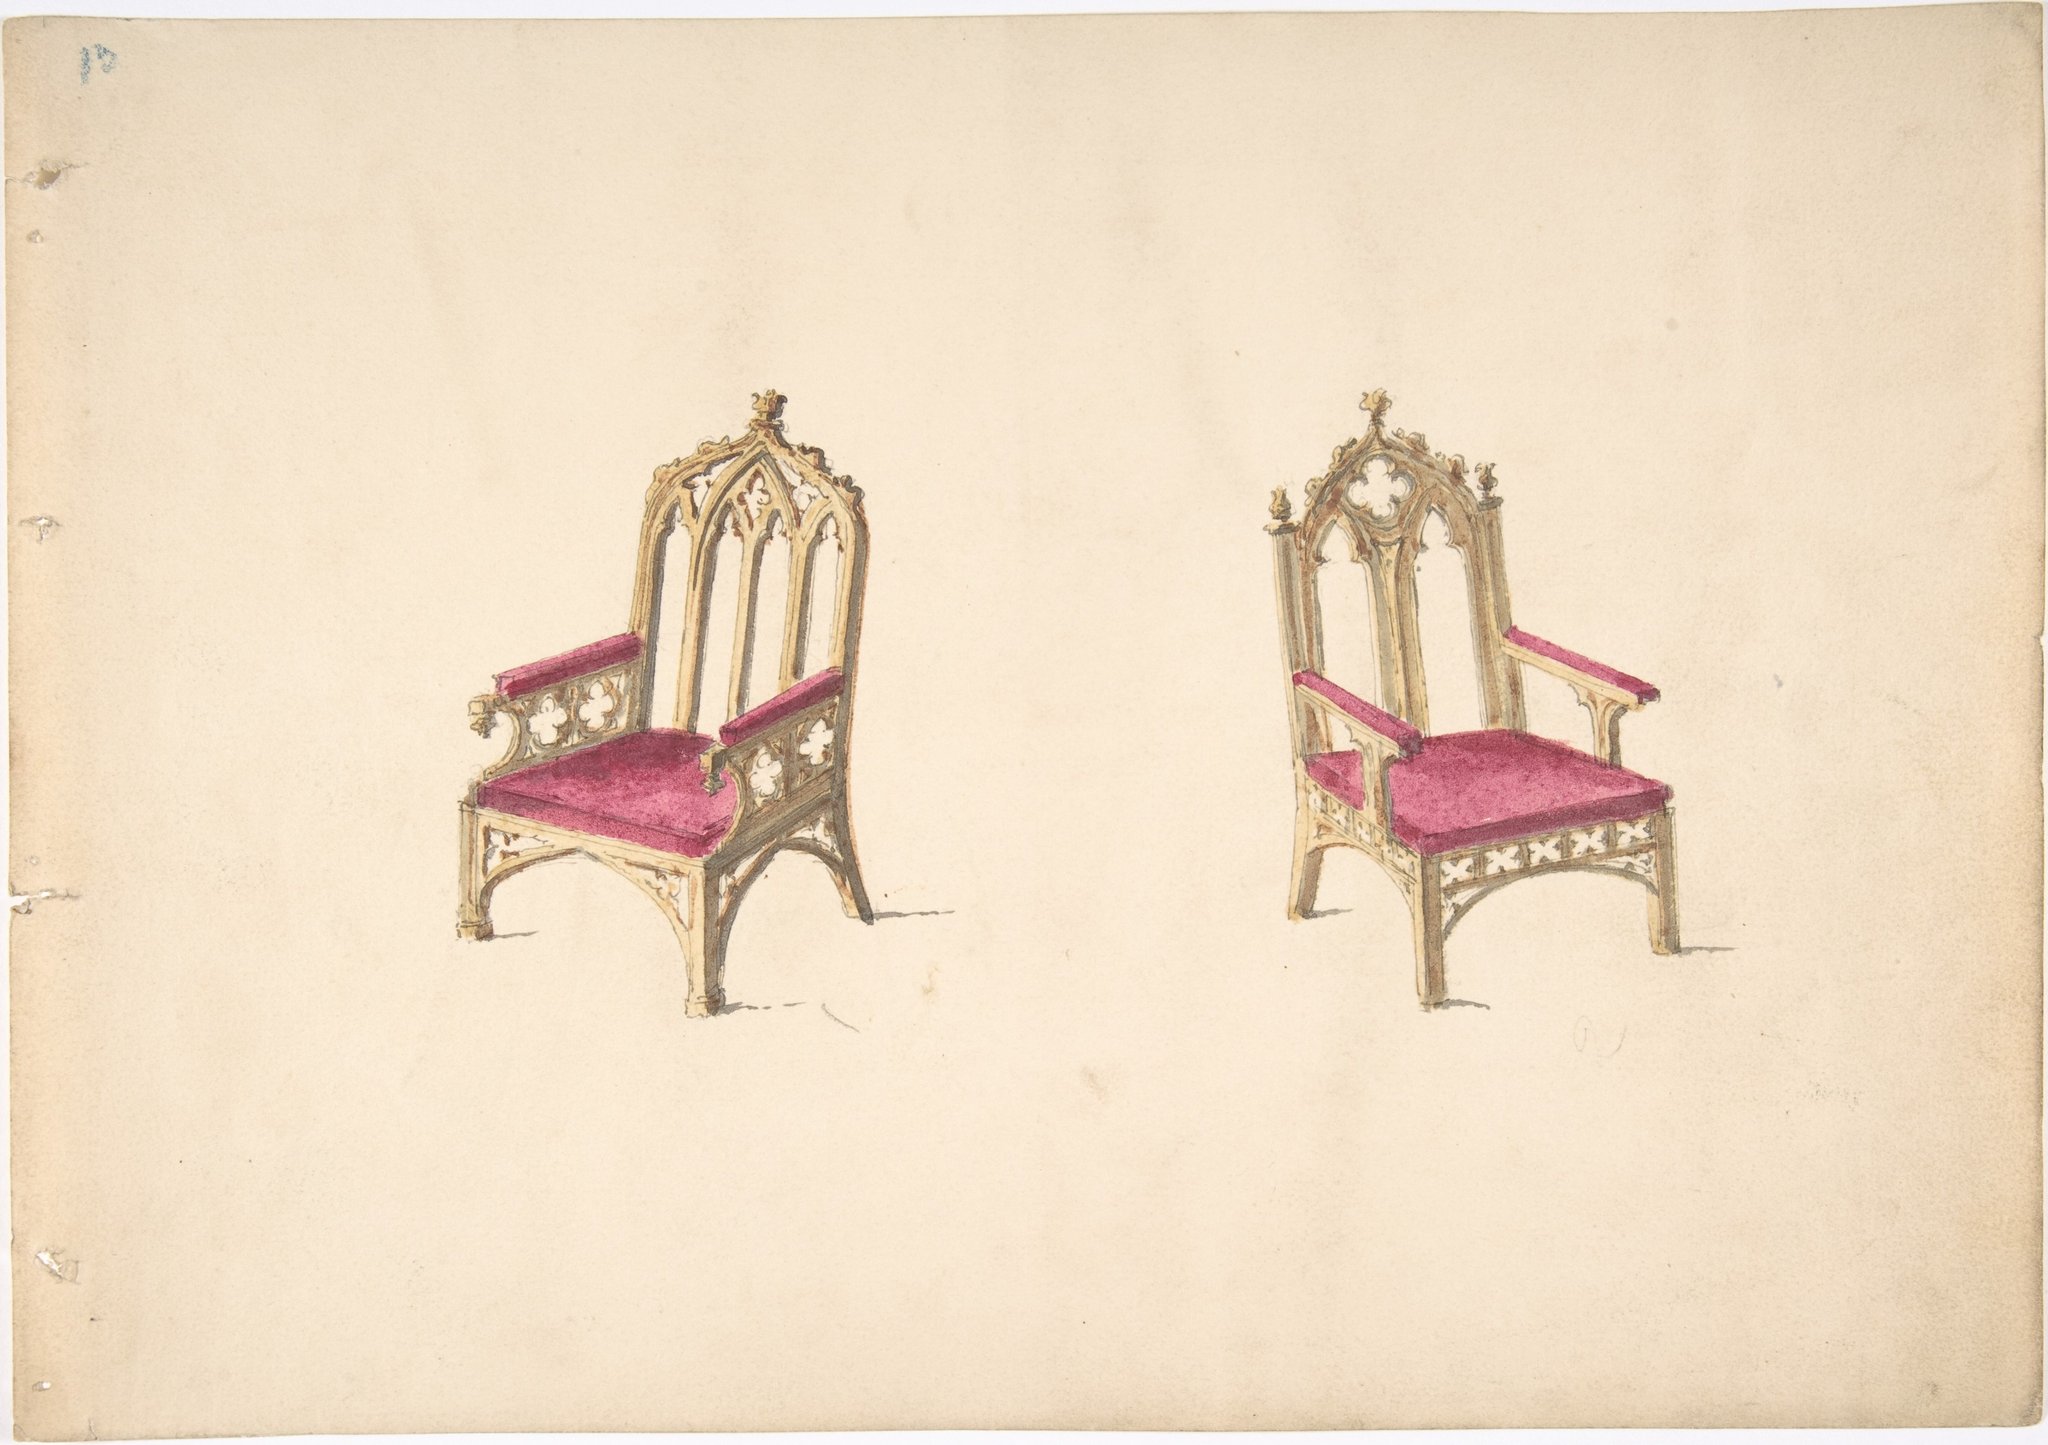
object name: drawing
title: Design for Two Gothic Style Armchairs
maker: anonymous, british, 19th century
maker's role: artist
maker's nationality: british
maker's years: 1800-1900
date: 1801-1833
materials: ink, watercolor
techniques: brush, pen, wash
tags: chairs